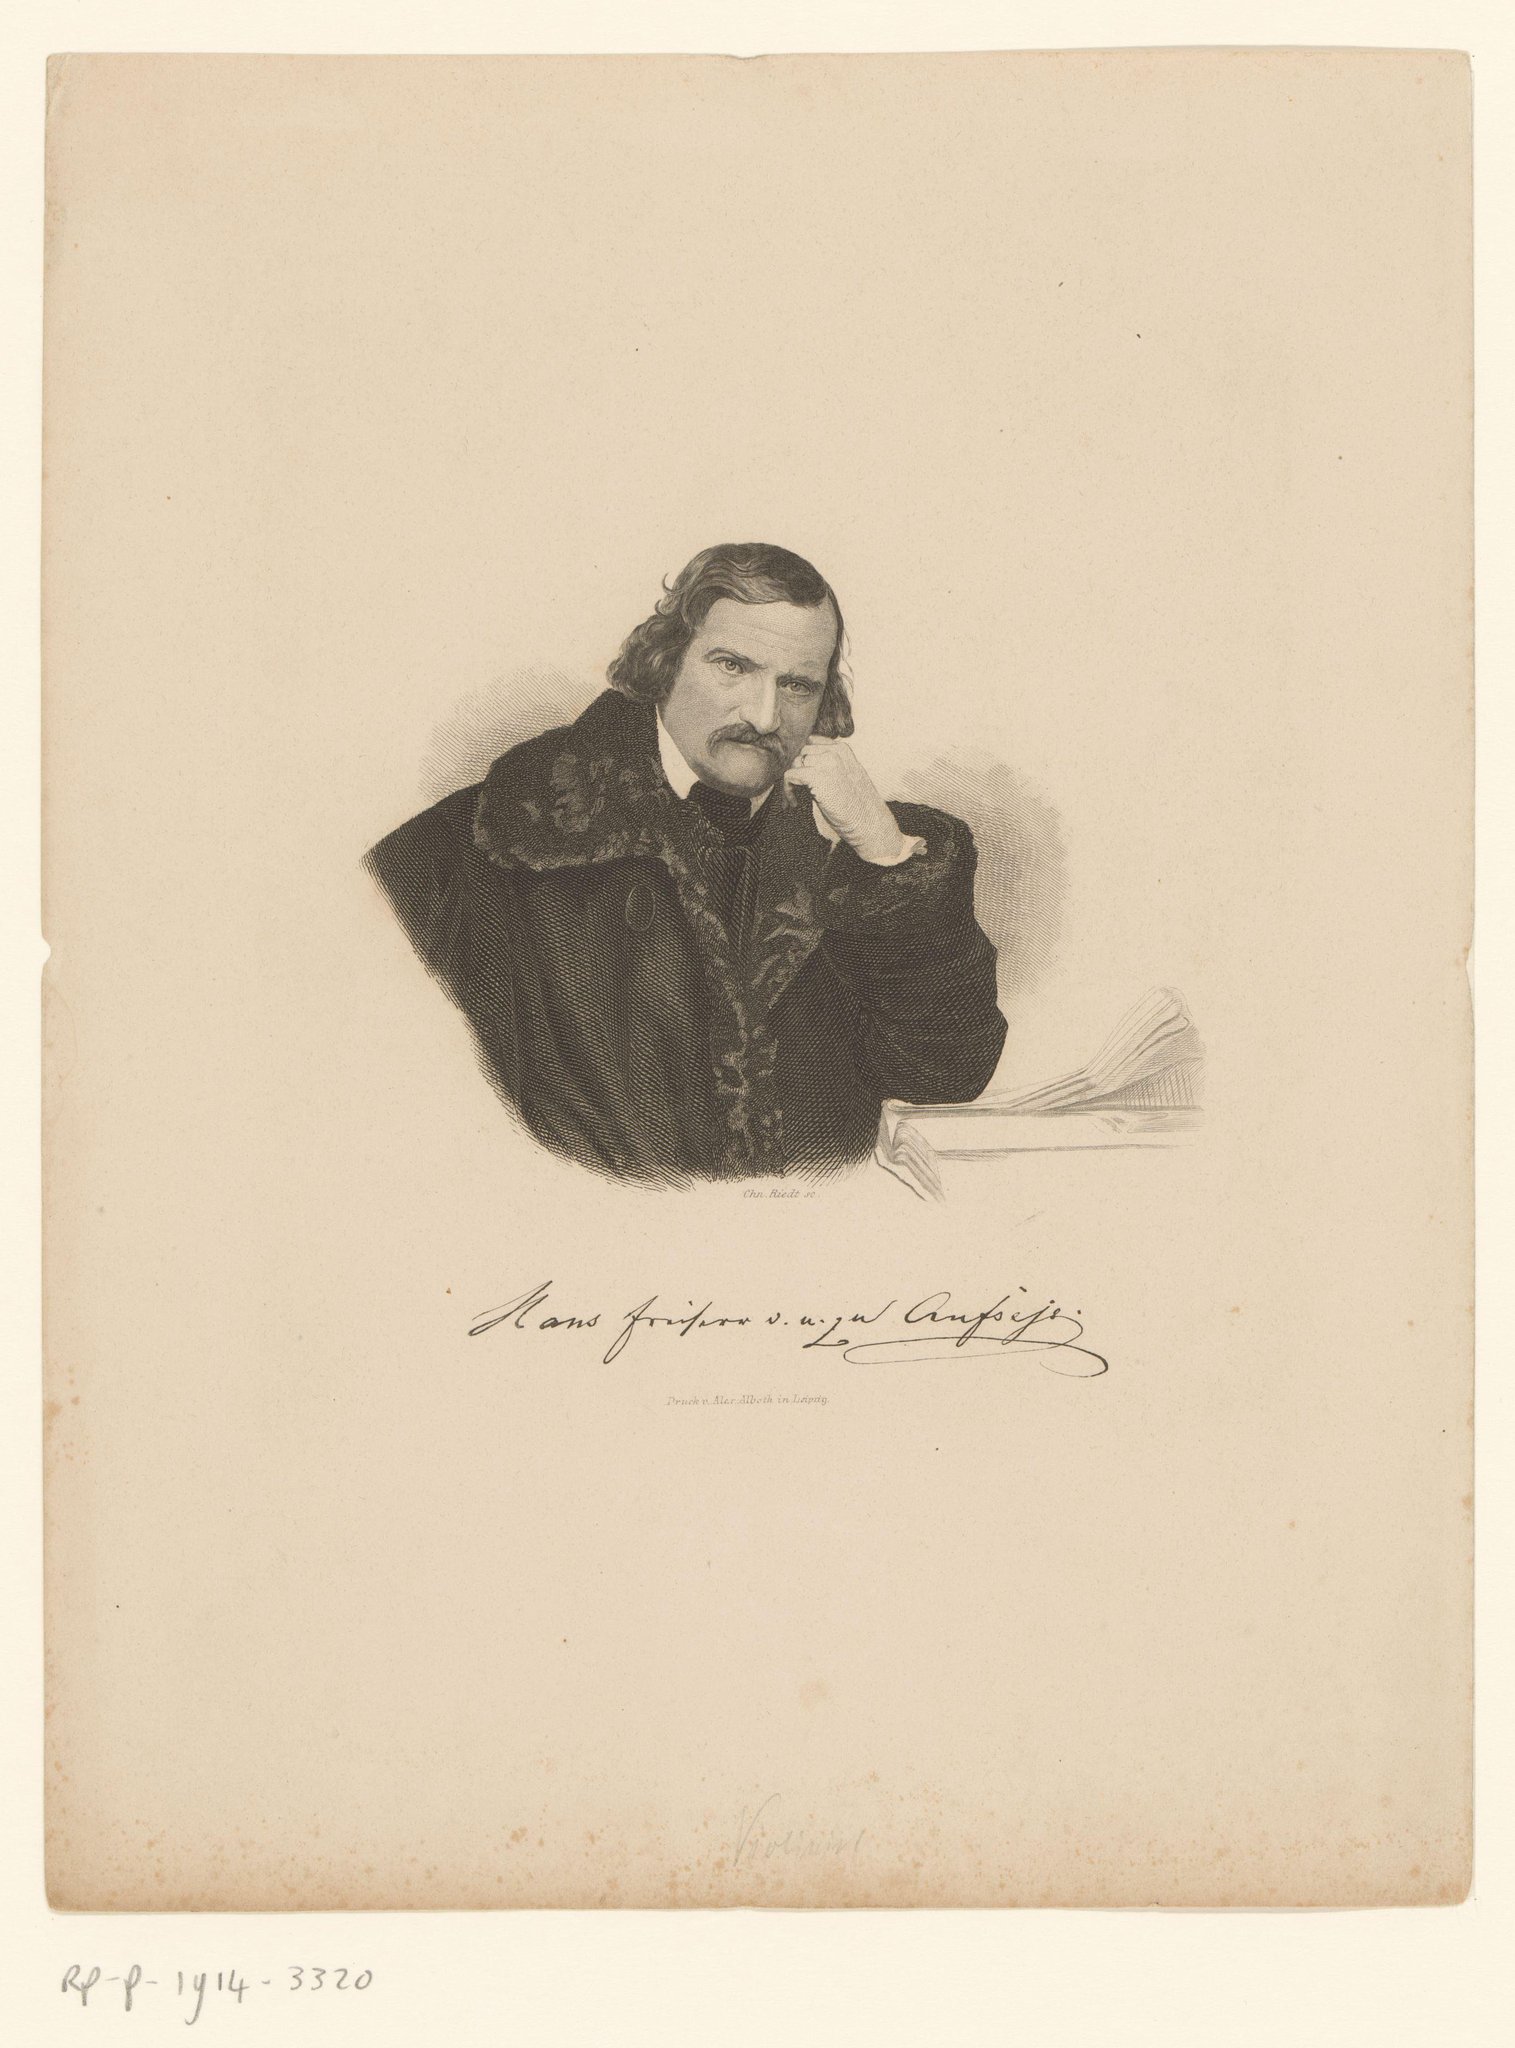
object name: print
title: Portret van Hans, Freiherr von und zu Aufsess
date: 1850-1914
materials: paper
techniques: engraving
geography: leipzig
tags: historical persons, book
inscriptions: collector's mark: Lugt 2228